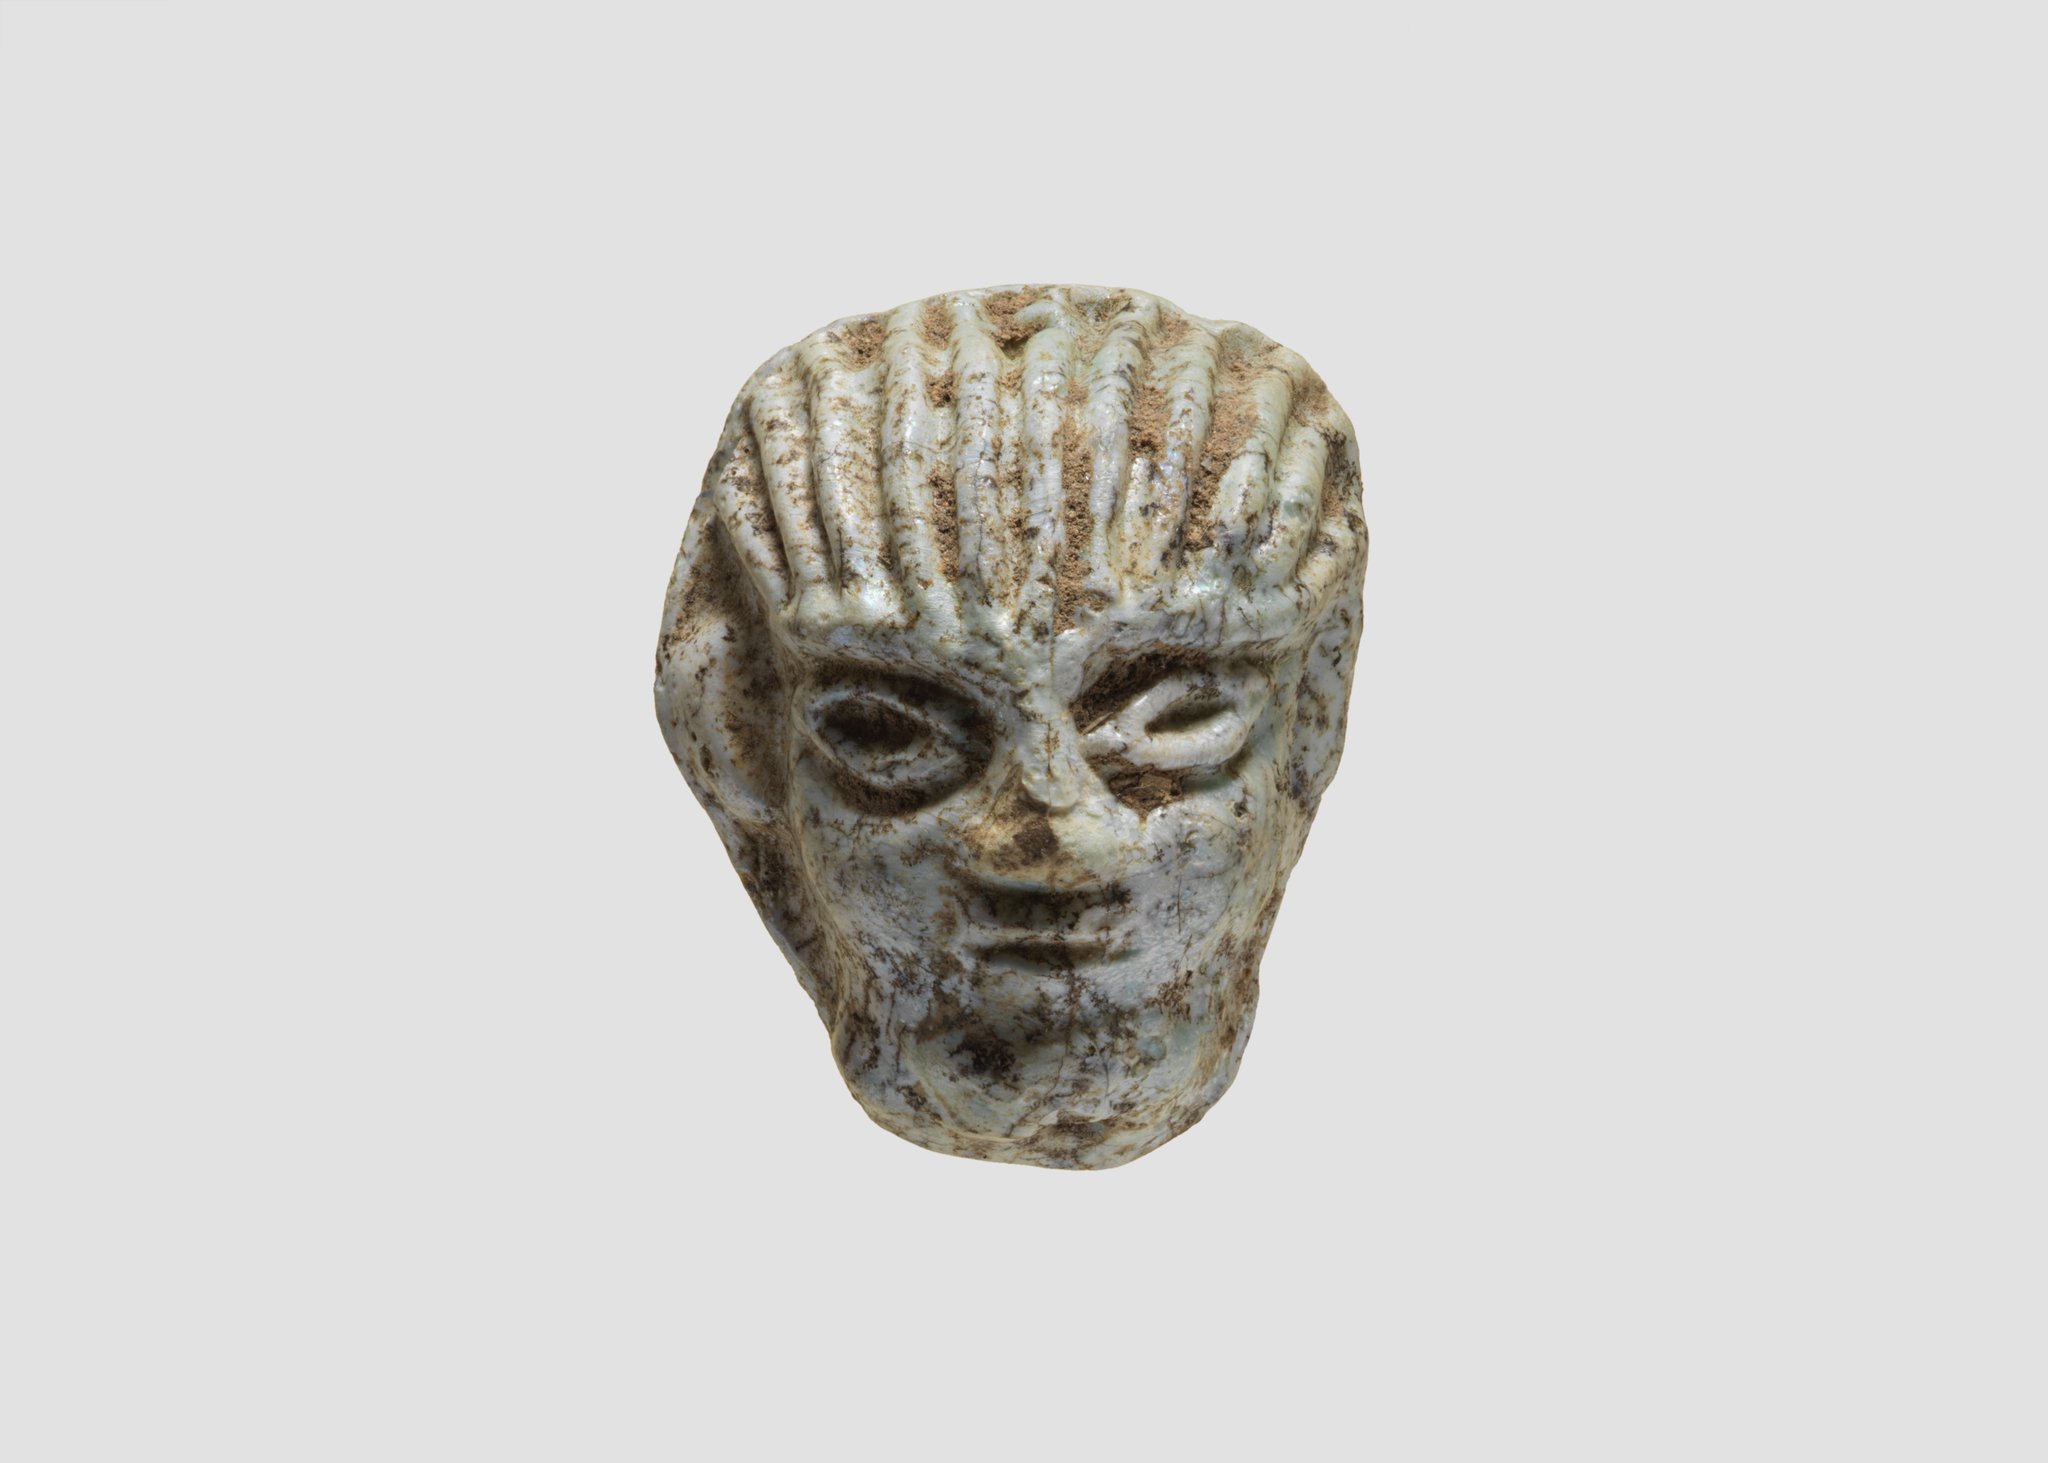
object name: ornament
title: Ornament: male head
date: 1500-1301 BCE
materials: glass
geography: mesopotamia or syria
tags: heads